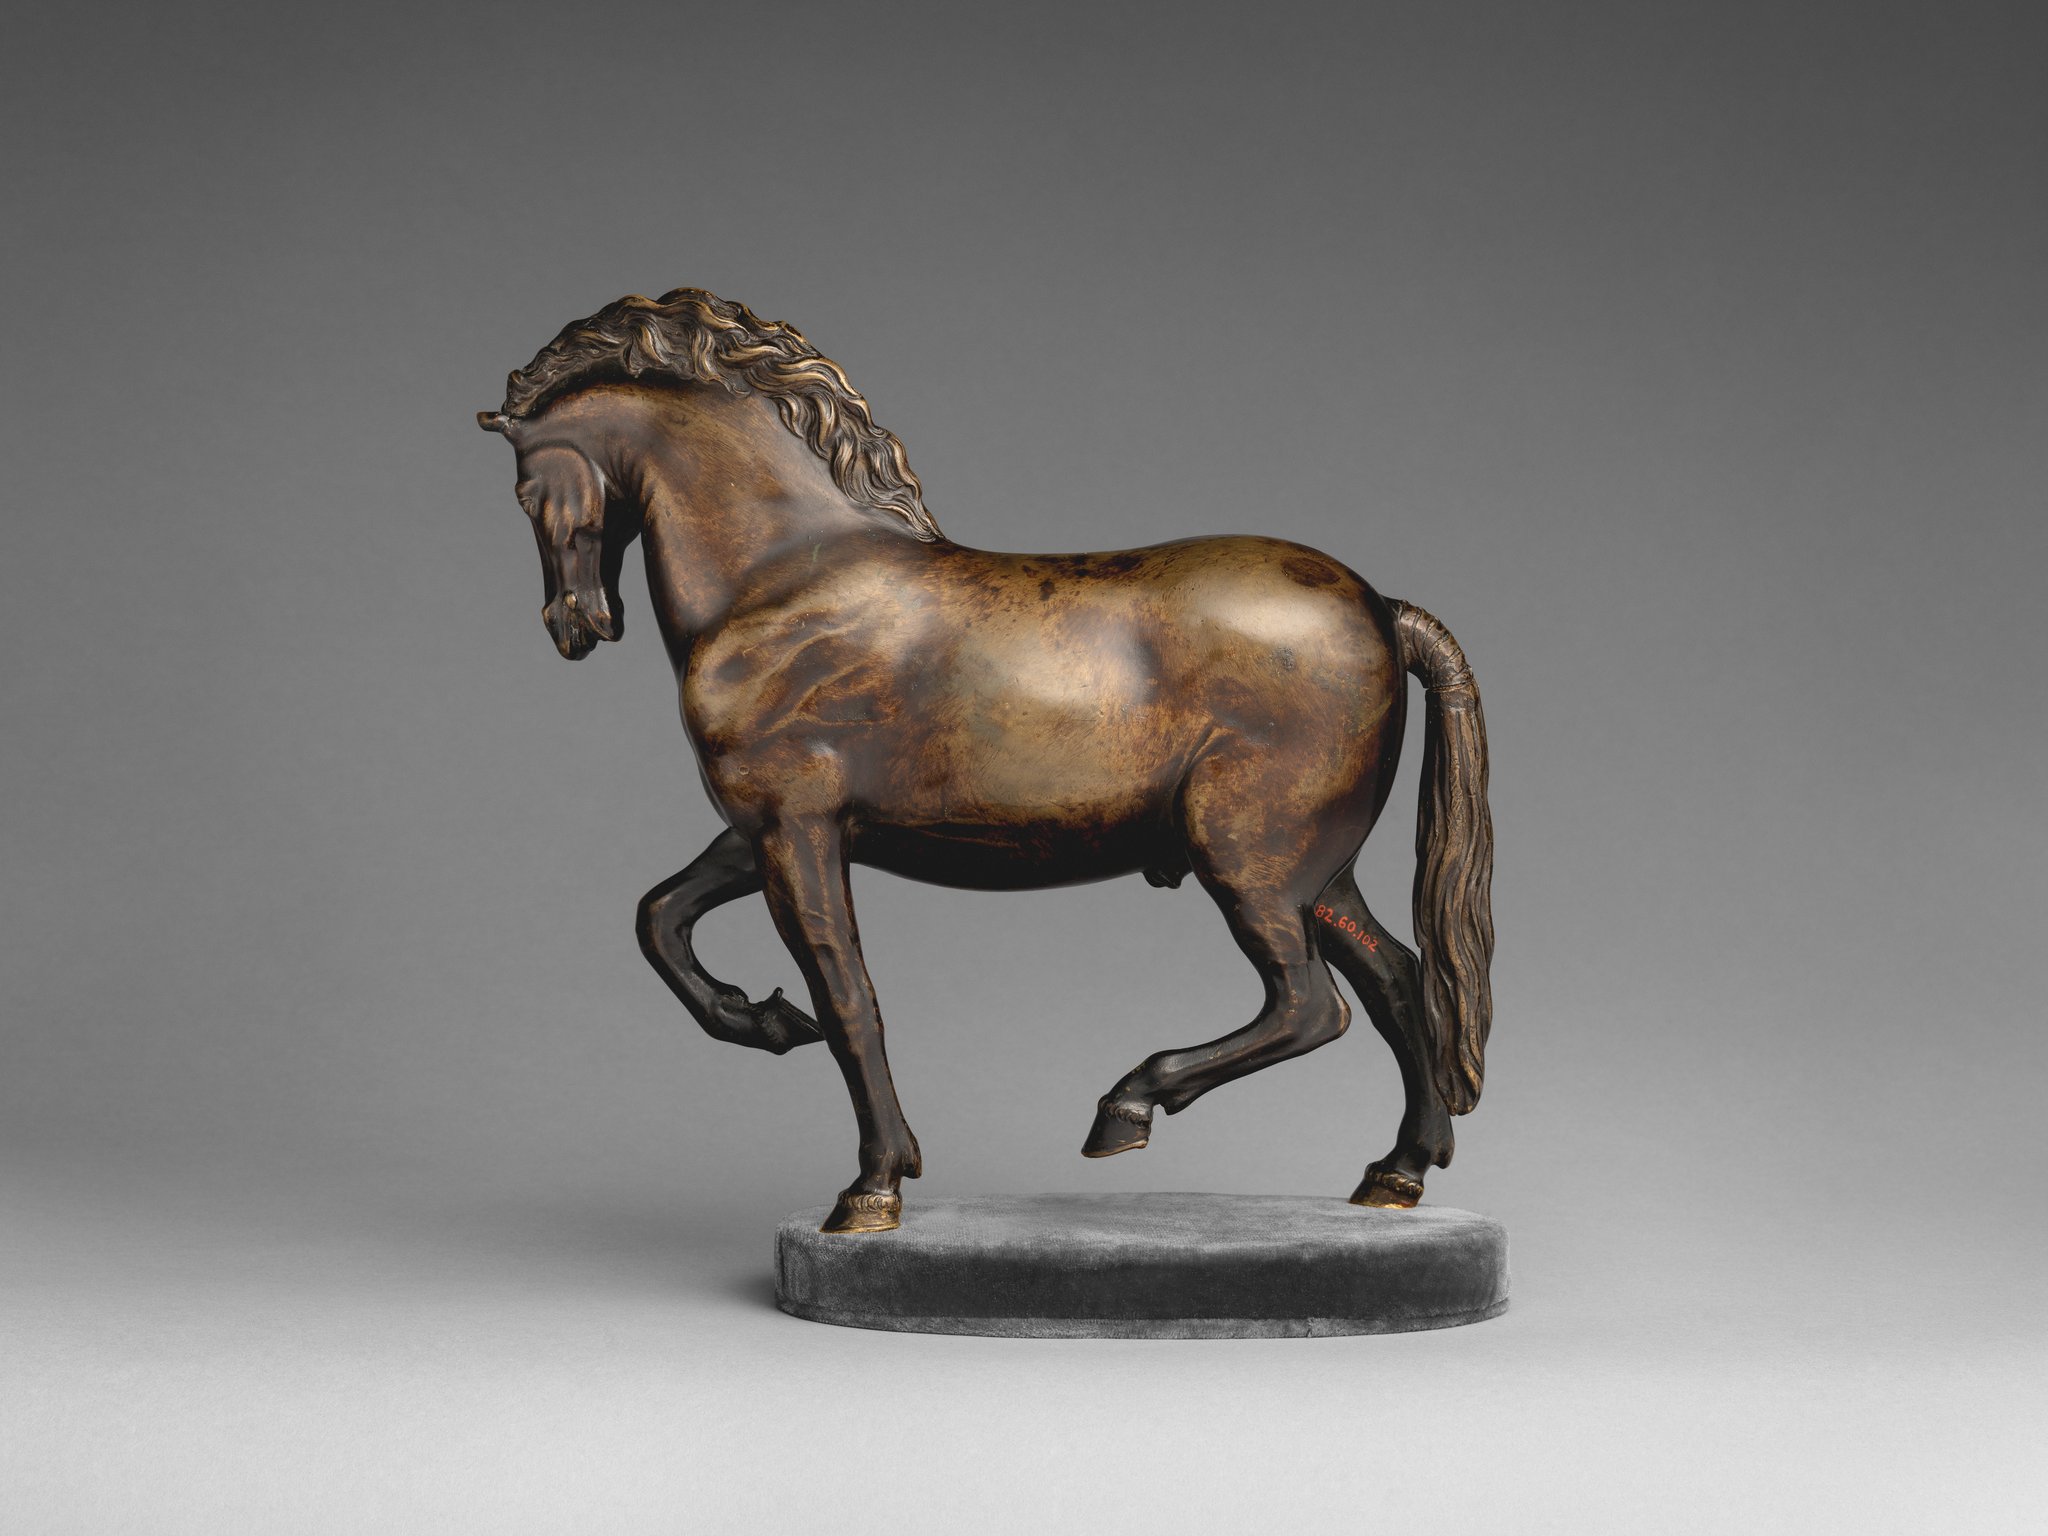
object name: statuette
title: Trotting horse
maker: giambologna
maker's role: artist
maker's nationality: netherlandish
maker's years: 1529-1608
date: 1701-1900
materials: bronze, lacquer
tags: horses